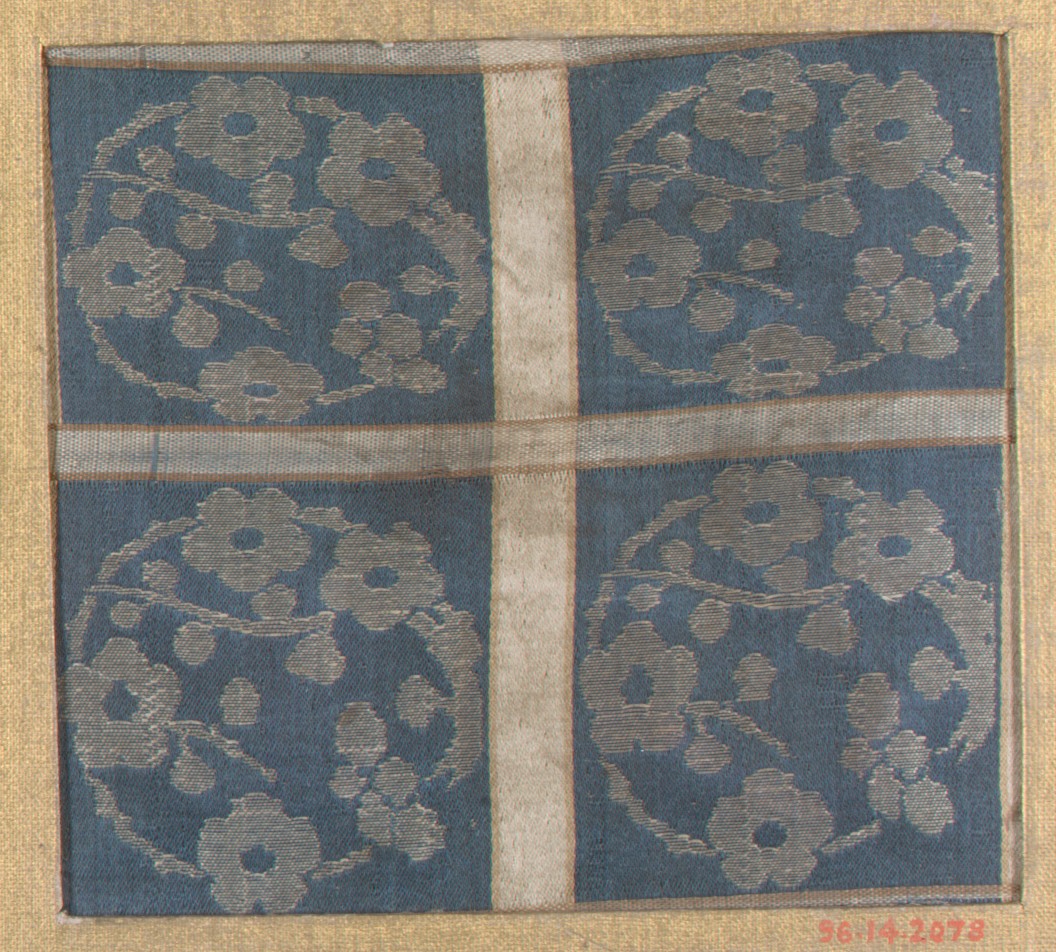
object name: piece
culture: japanese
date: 1701-1900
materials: silk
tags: flowers